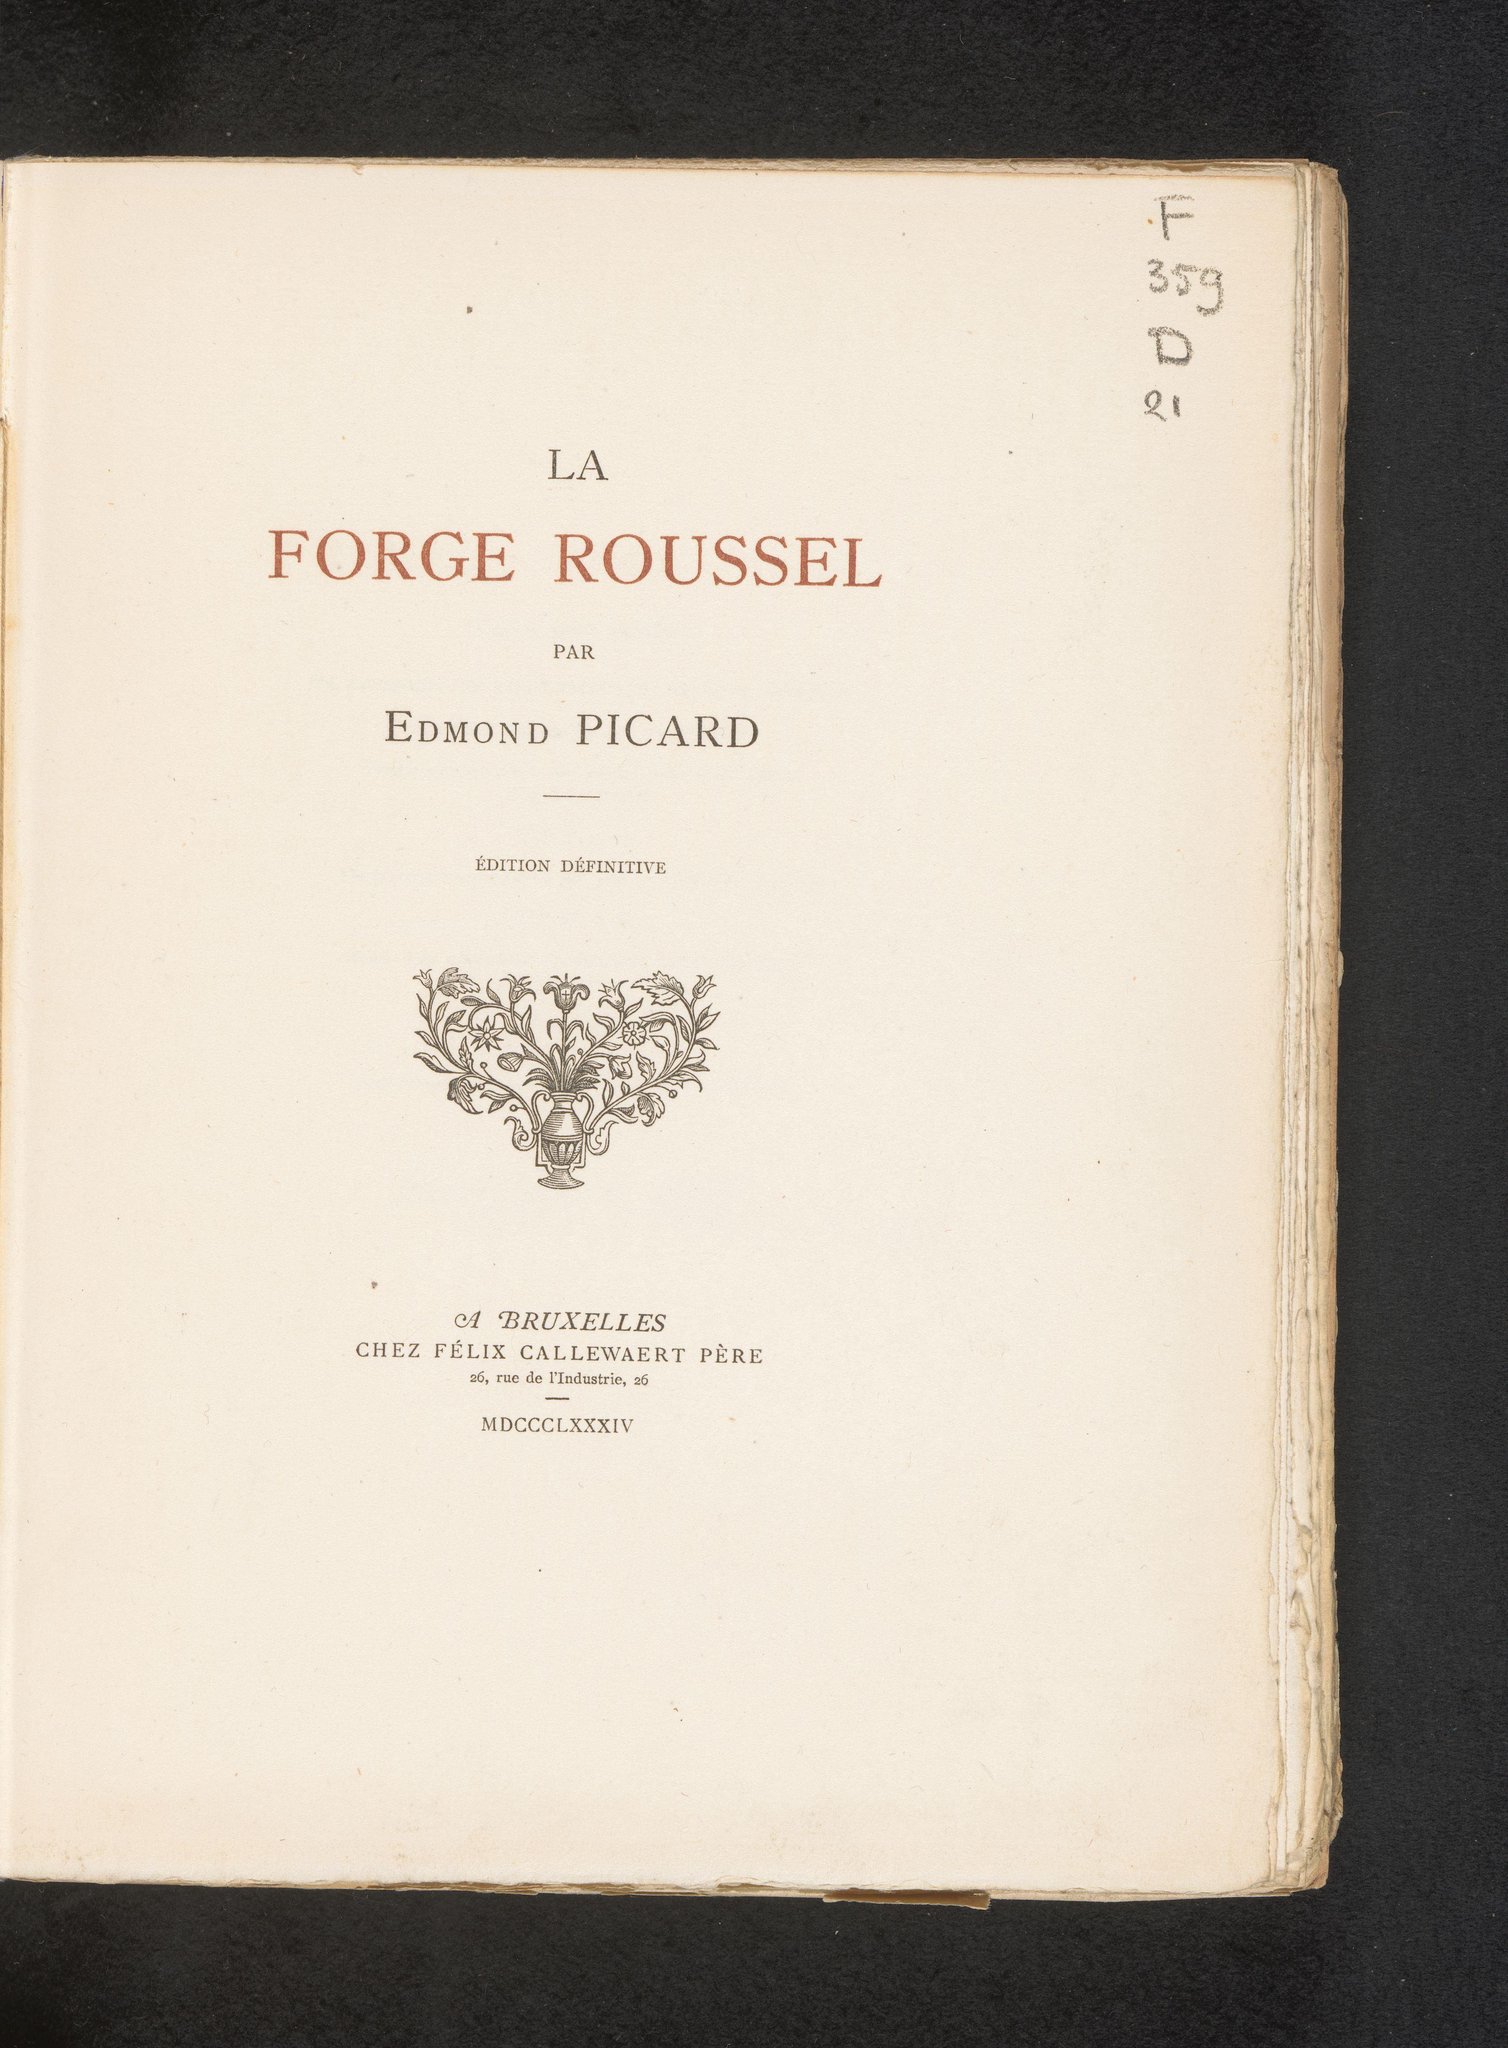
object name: book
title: La forge Roussel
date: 1884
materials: paper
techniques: photoaquatint, printing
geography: brussels